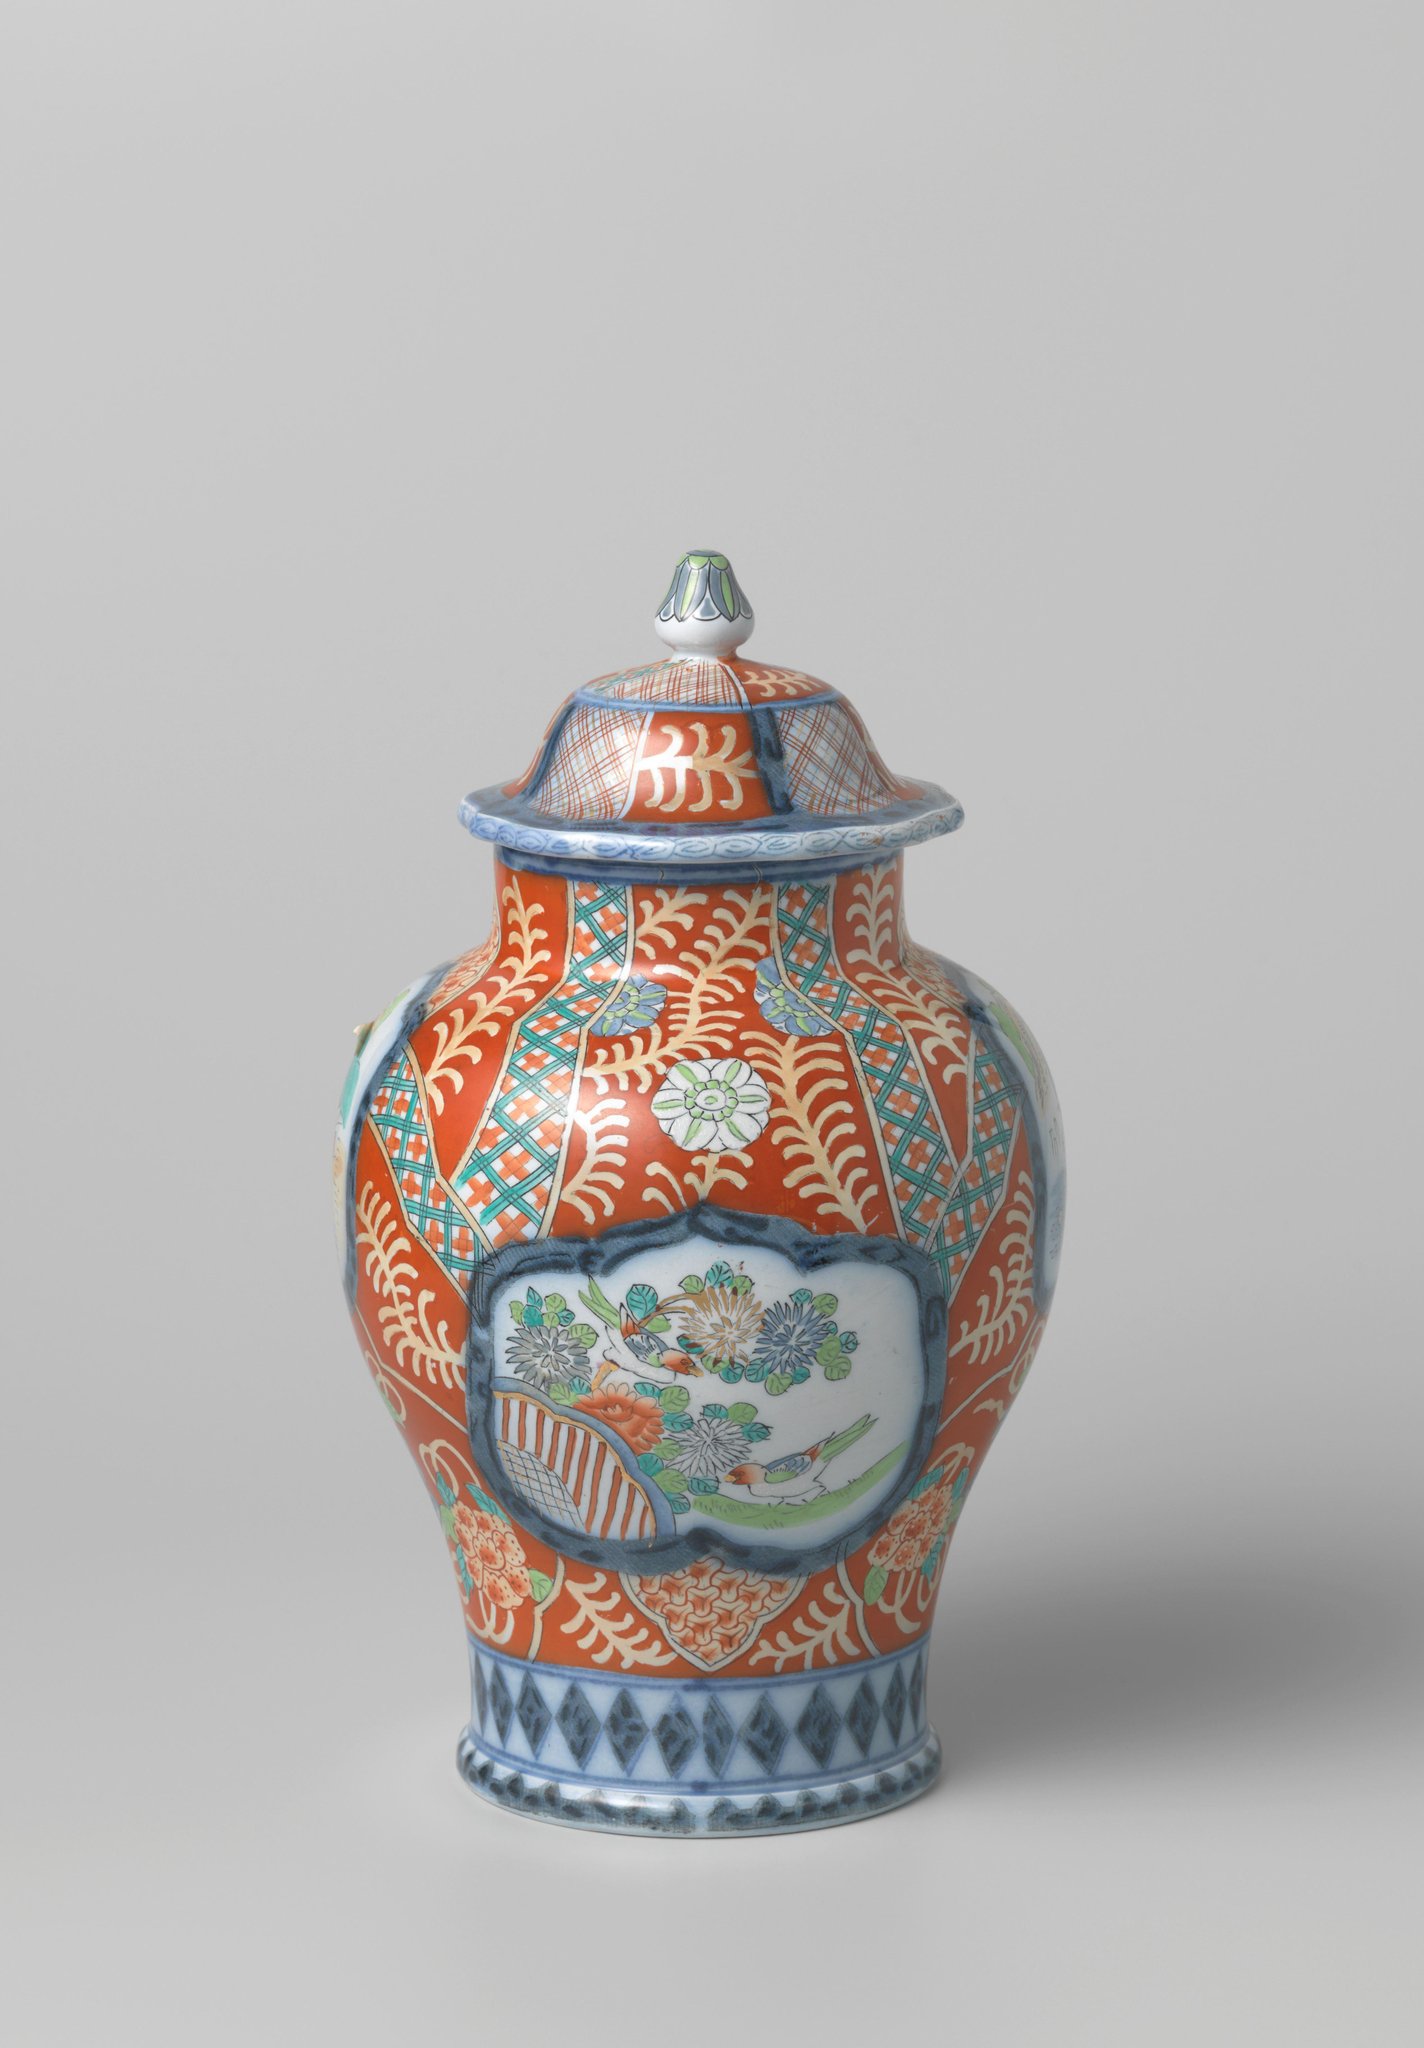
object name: covered jar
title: Dekselpot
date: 1886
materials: earthenware, glaze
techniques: vitrification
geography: maastricht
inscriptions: mark: ‘Sfinx // P. REGOUT & Co // MAASTRICHT’, check stamp: ‘3’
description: Dekselpot van aardewerk, behorend bij een driedelig kaststel, met zwarte en vloeiblauwe transferdecoratie, beschilderd met emailkleuren en okerluster, met goud gehoogd. Op de buik twee cartouches met vogels en takken, en twee cartouches met een landschap.